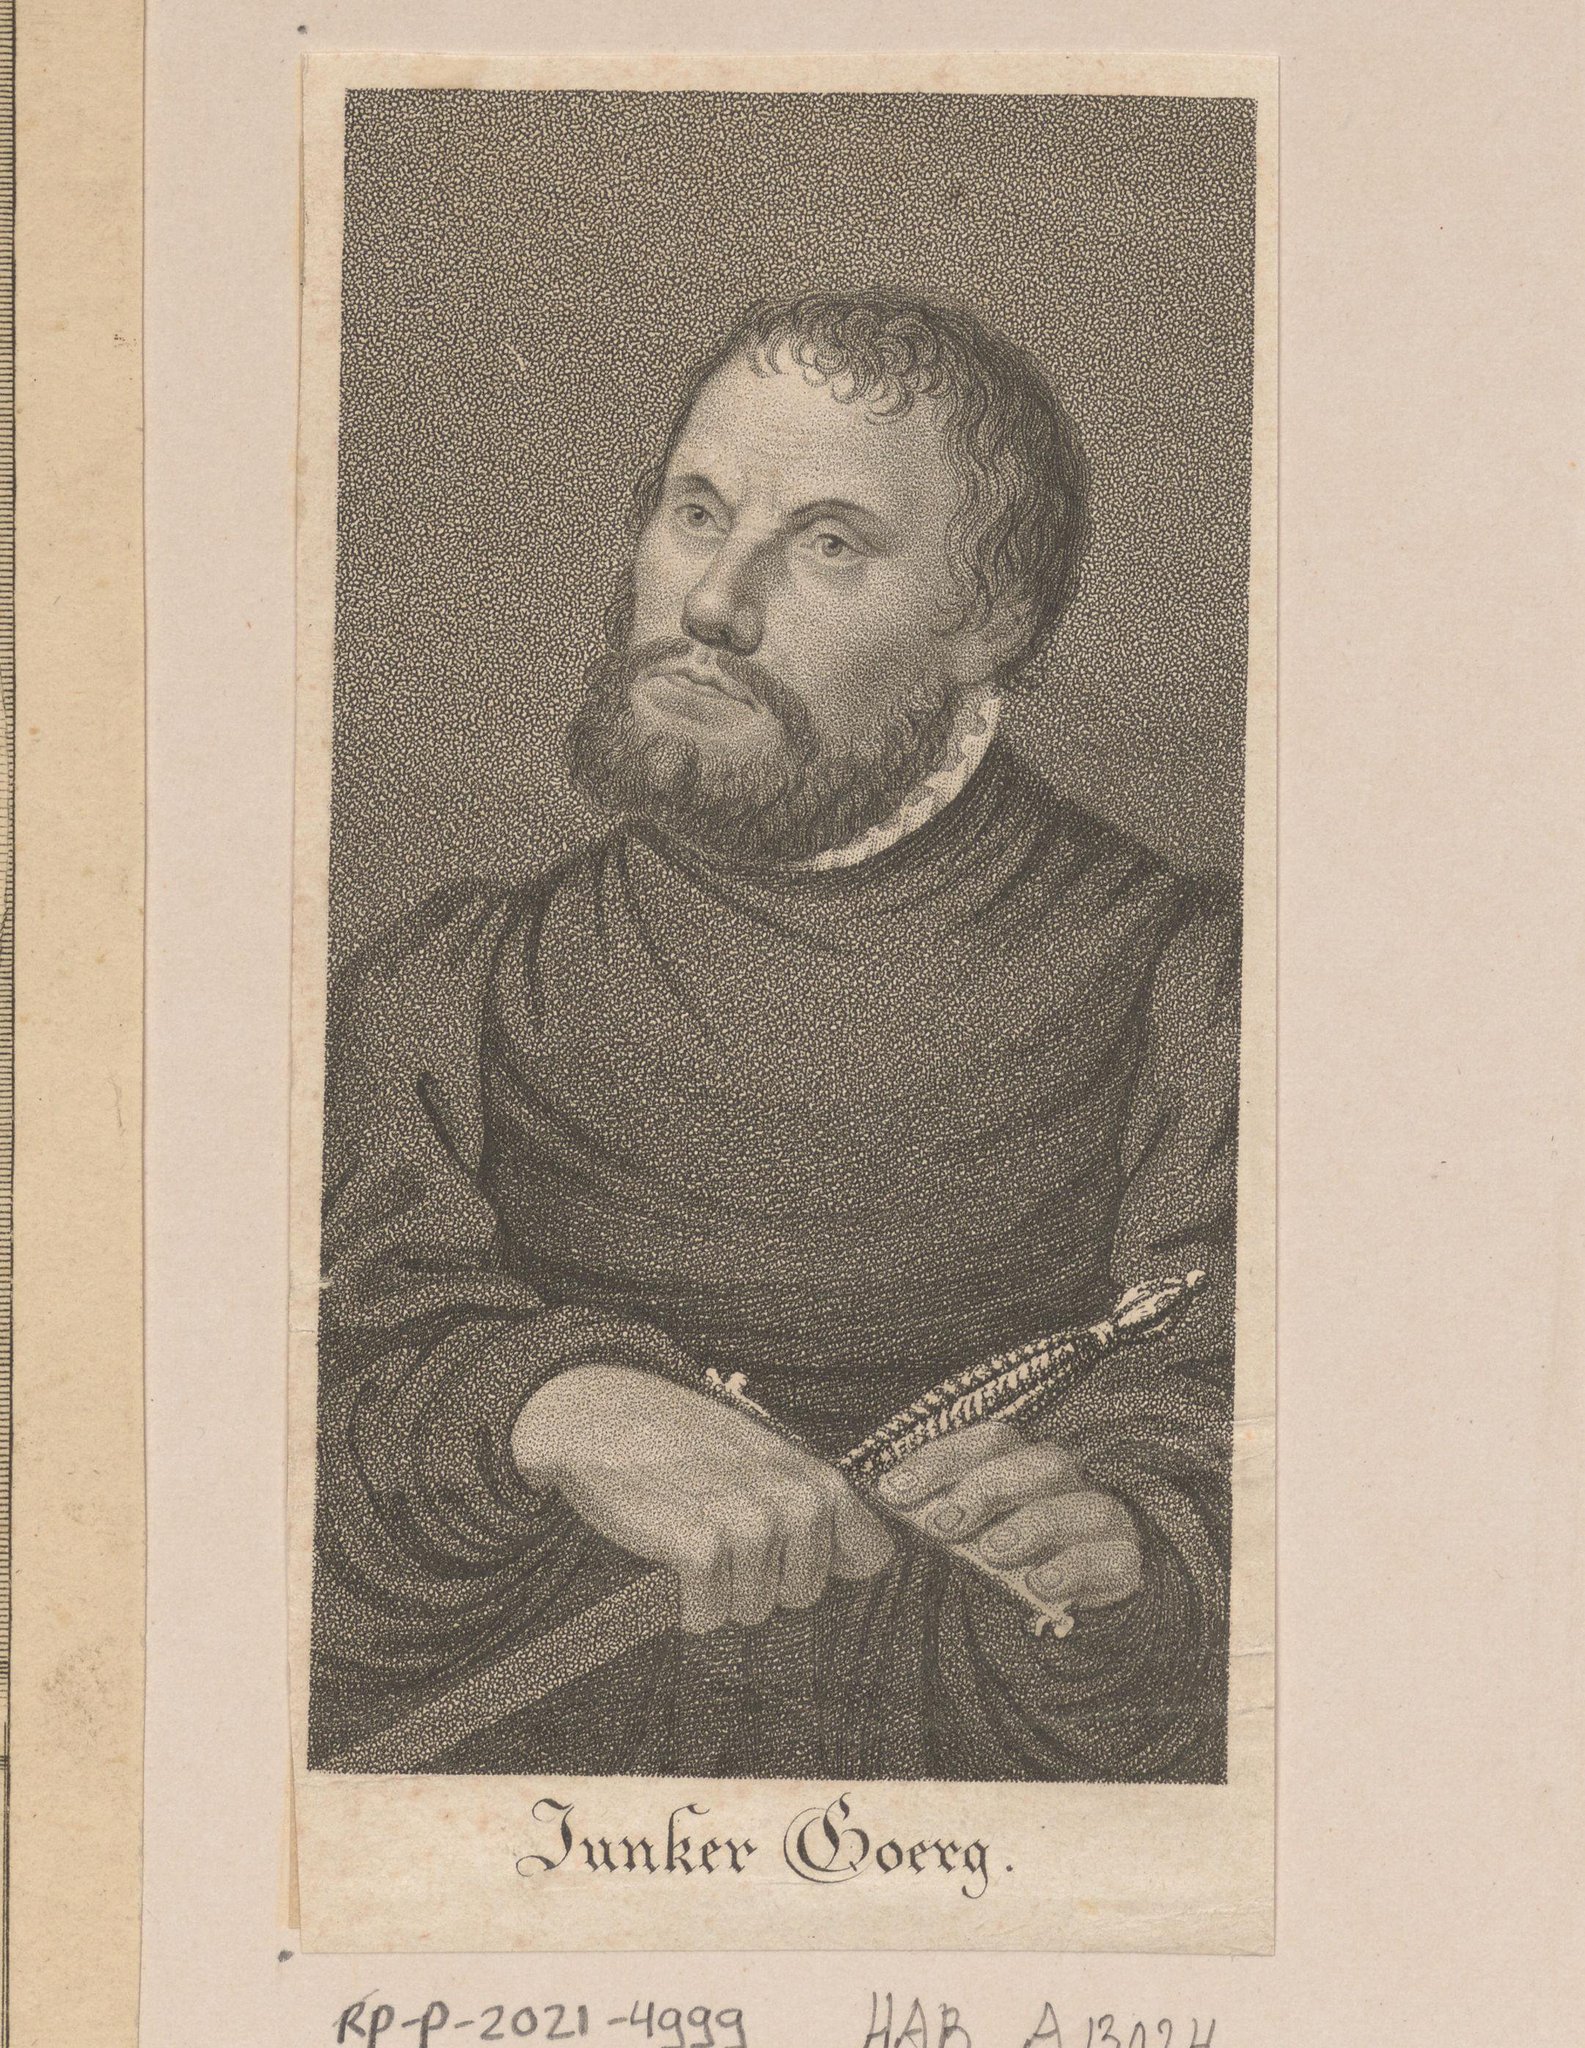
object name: print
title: Portret van Martin Luther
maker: friedrich wilhelm meyer (i)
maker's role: print maker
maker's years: 1760-1880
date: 1817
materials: paper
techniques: aquatint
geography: germany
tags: priest, martin luther, theologian, historical persons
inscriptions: collector's mark: Lugt 2228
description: Prent waarschijnlijk uit: Reformations-Almanach für Luthers Verehrer auf das evangelische Jubeljahr 1817. Erfurt: Friedrich Keyser, 1817.